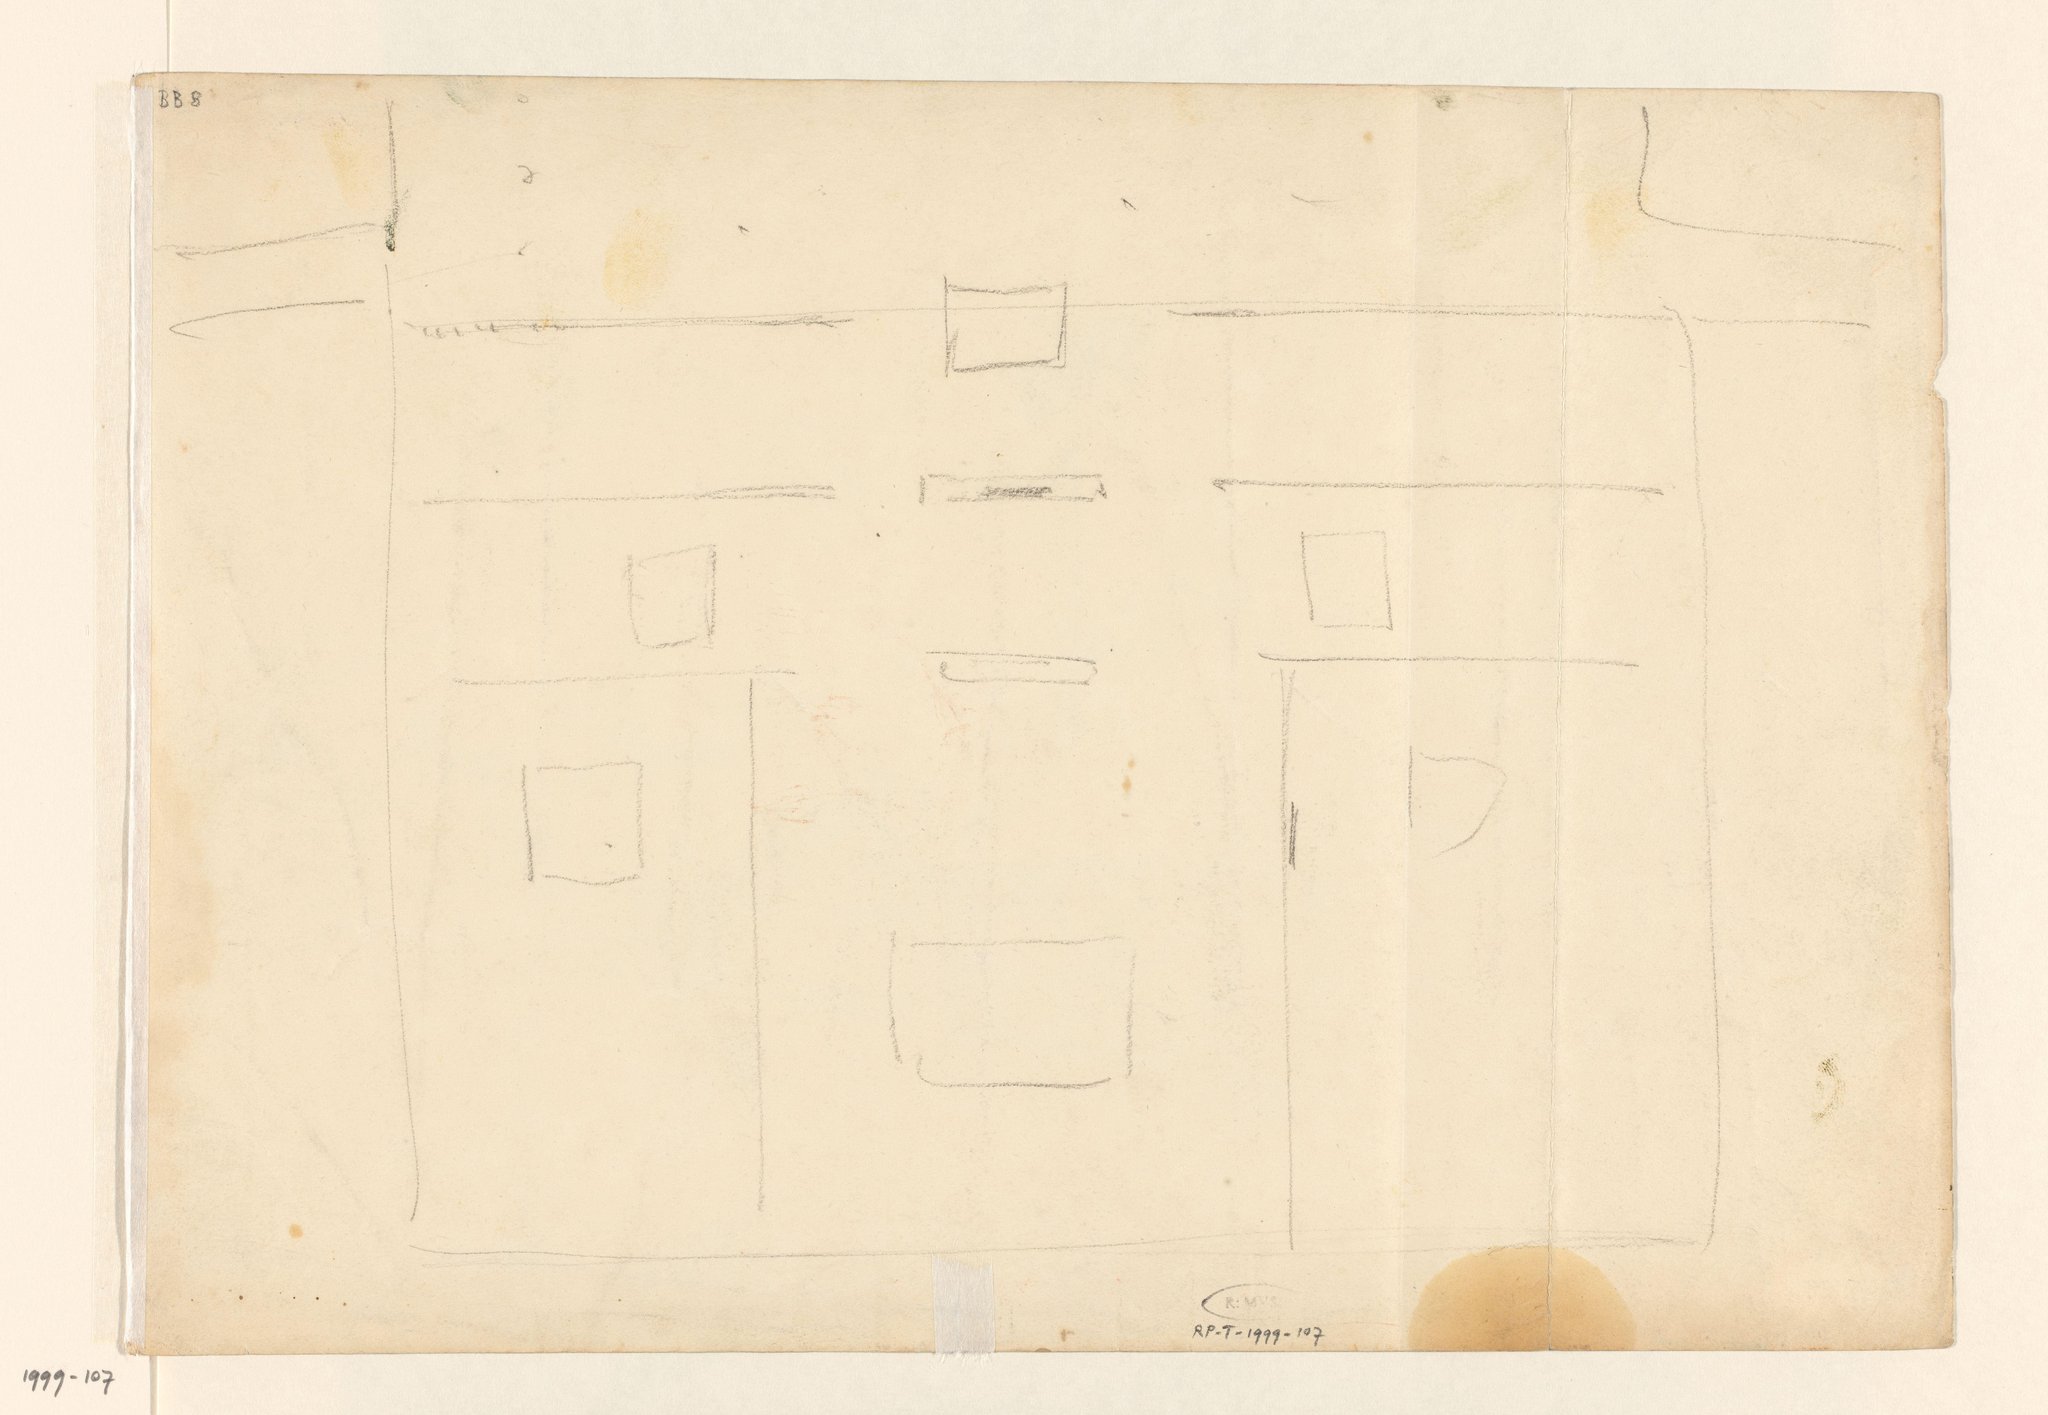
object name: topographical view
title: Geometrische opstelling van blokjes en lijnen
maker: adrianus johannes bik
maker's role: draughtsman, print maker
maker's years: 1790-1872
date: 1816-1846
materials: chalk, paper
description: artikel over deze collectie in Bulletin van het Rijksmuseum 49 [2001], nr. 4, pp 342 e.v.